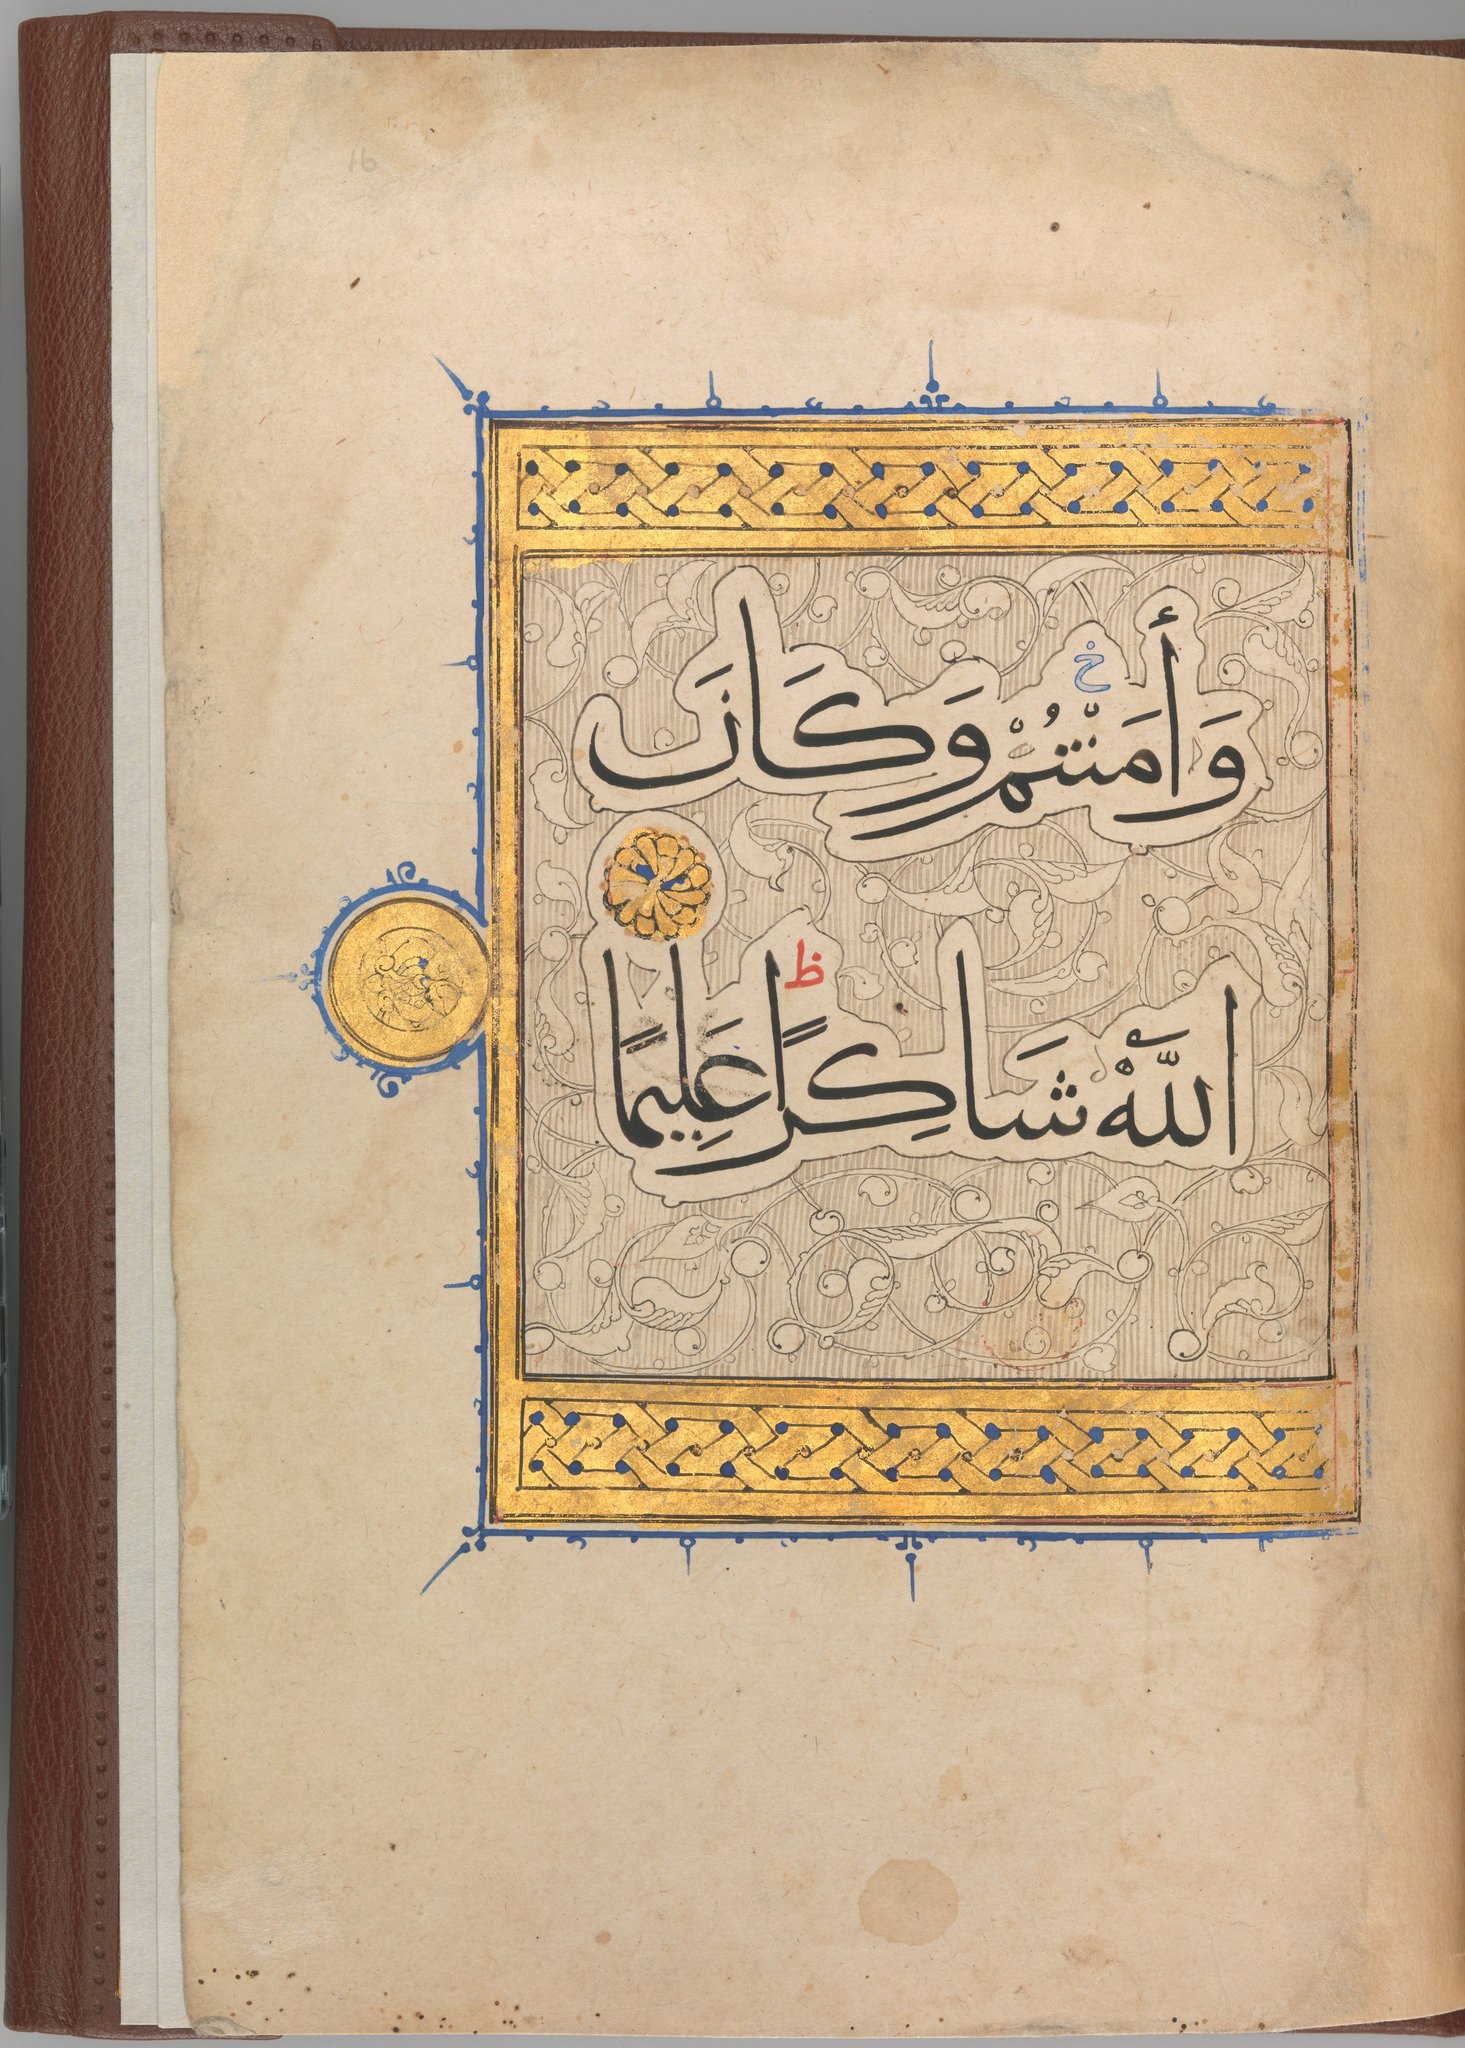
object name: section from a non illustrated manuscript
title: Section from a Qur'an Manuscript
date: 1320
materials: gold, ink, leather, paper, watercolor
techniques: bookbinding, tooling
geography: egypt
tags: qur'an,calligraphy